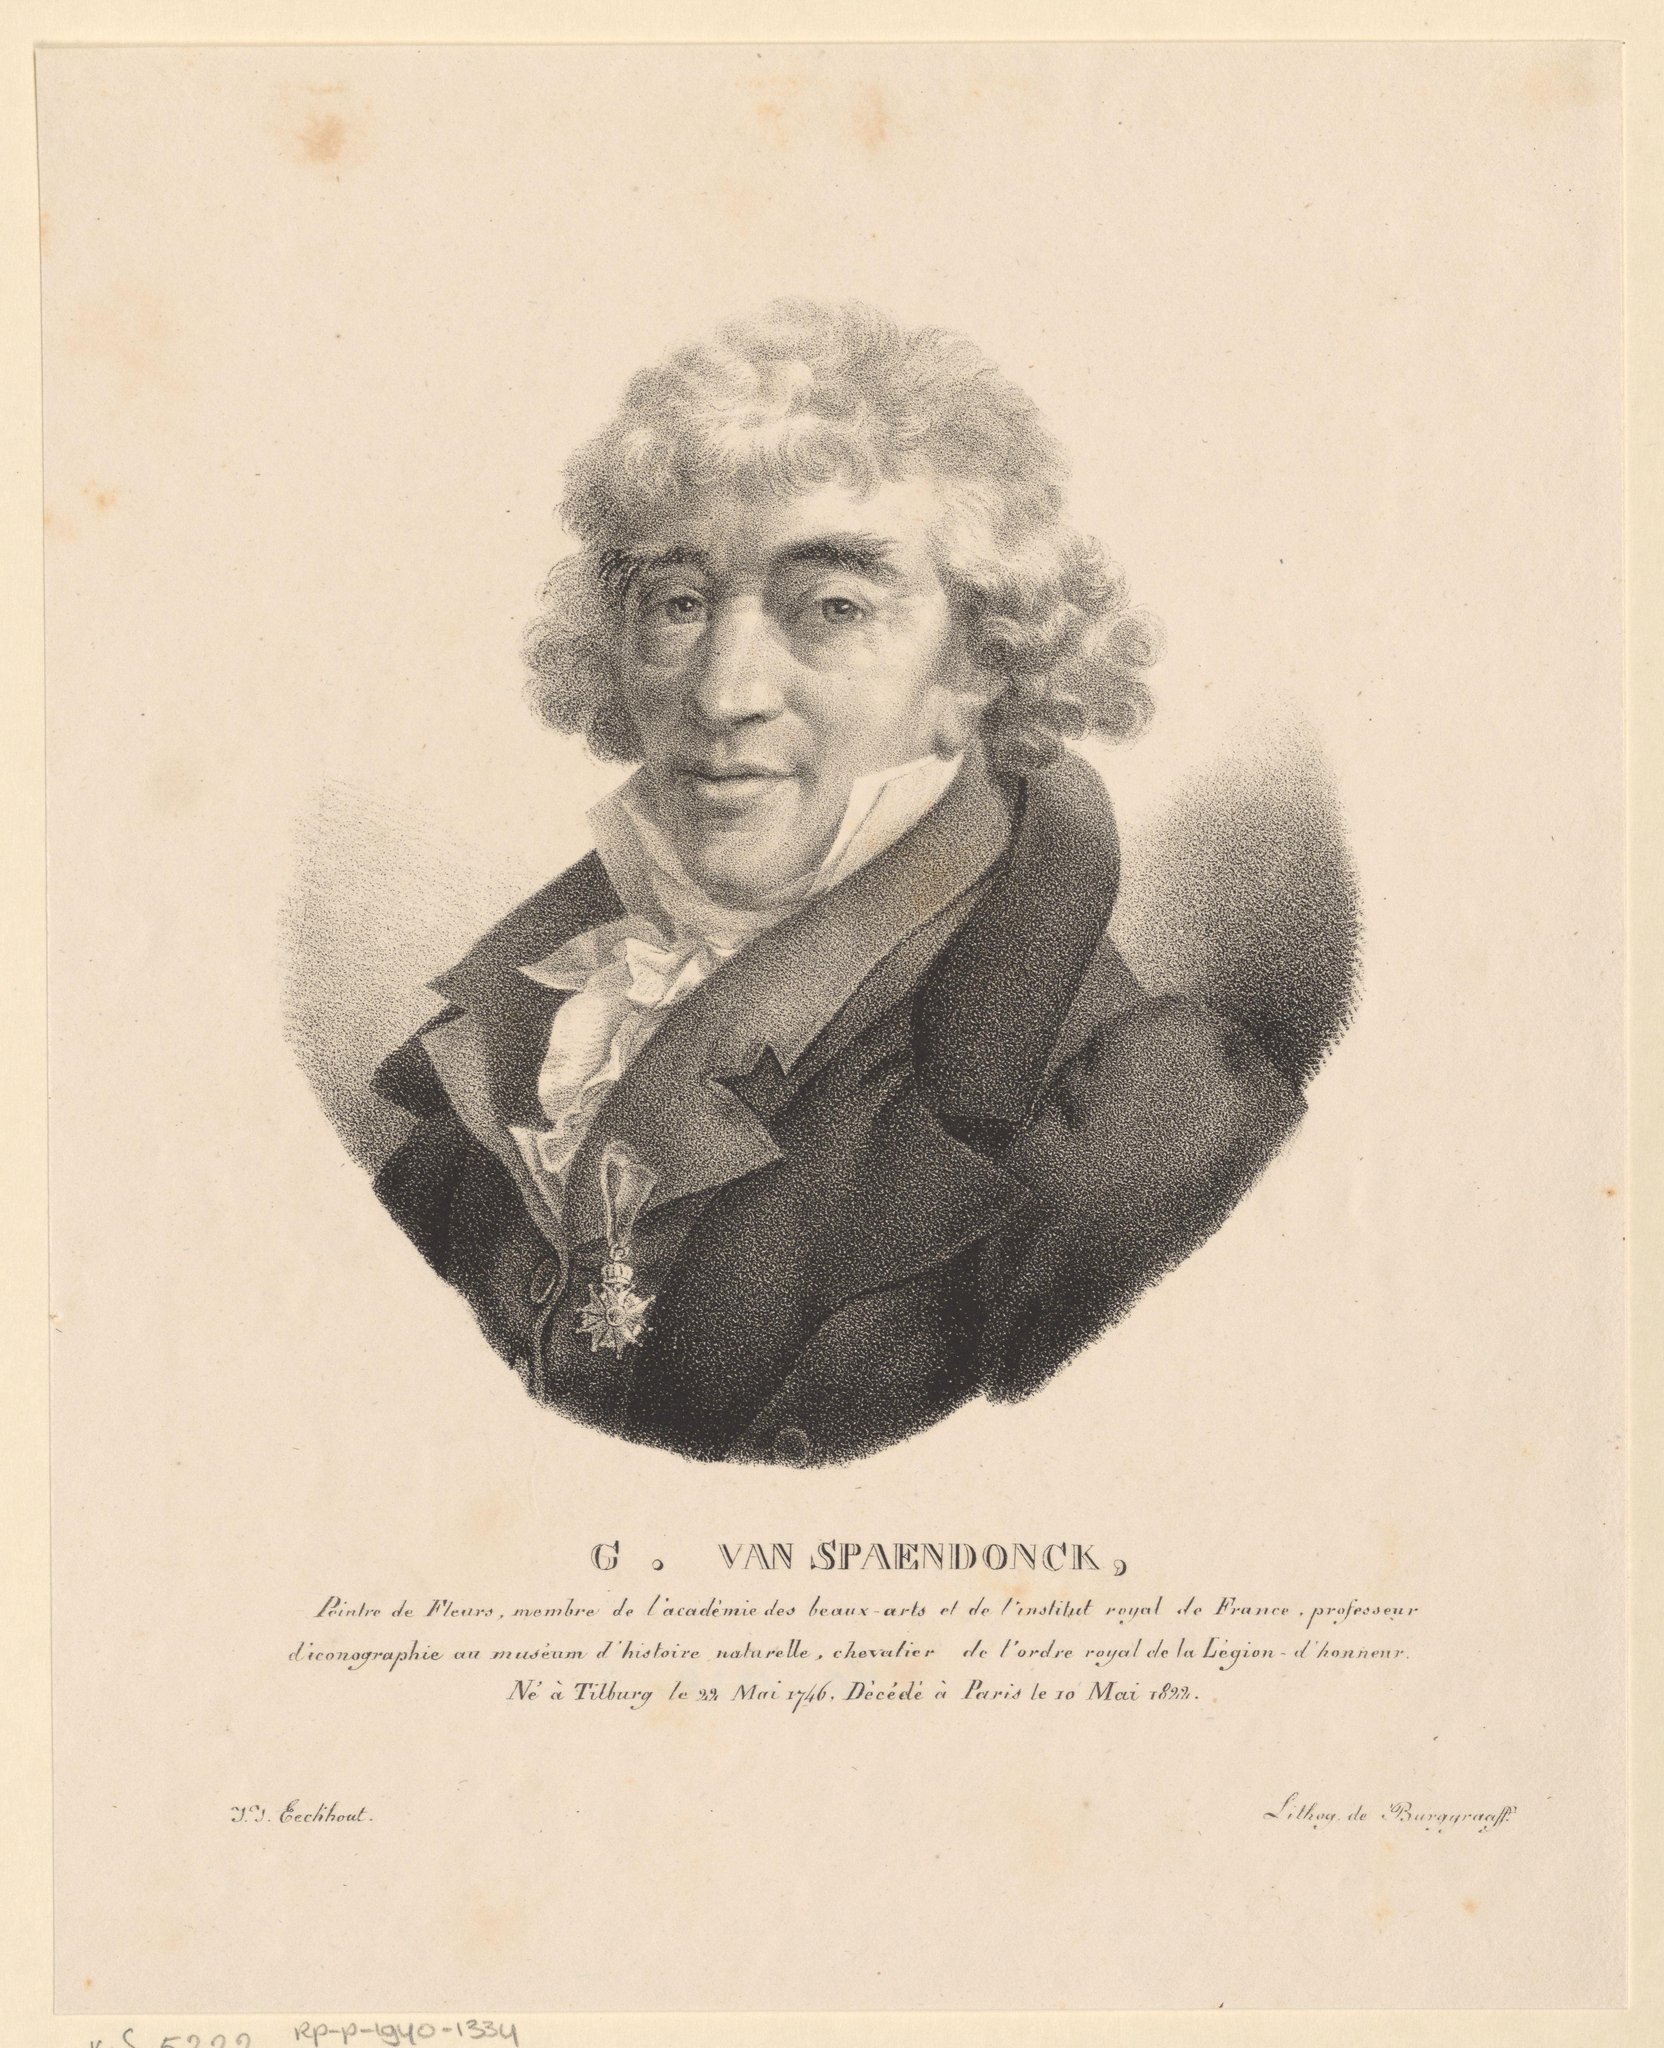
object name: print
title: Portretten van hedendaagse kunstenaars uit het Verenigd Koninkrijk der Nederlanden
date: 1822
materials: paper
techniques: lithograph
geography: brussels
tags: print maker, gerard van spaendonck, historical persons, portrait, self-portrait of artist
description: Met drieregelig onderschrift in het Frans.